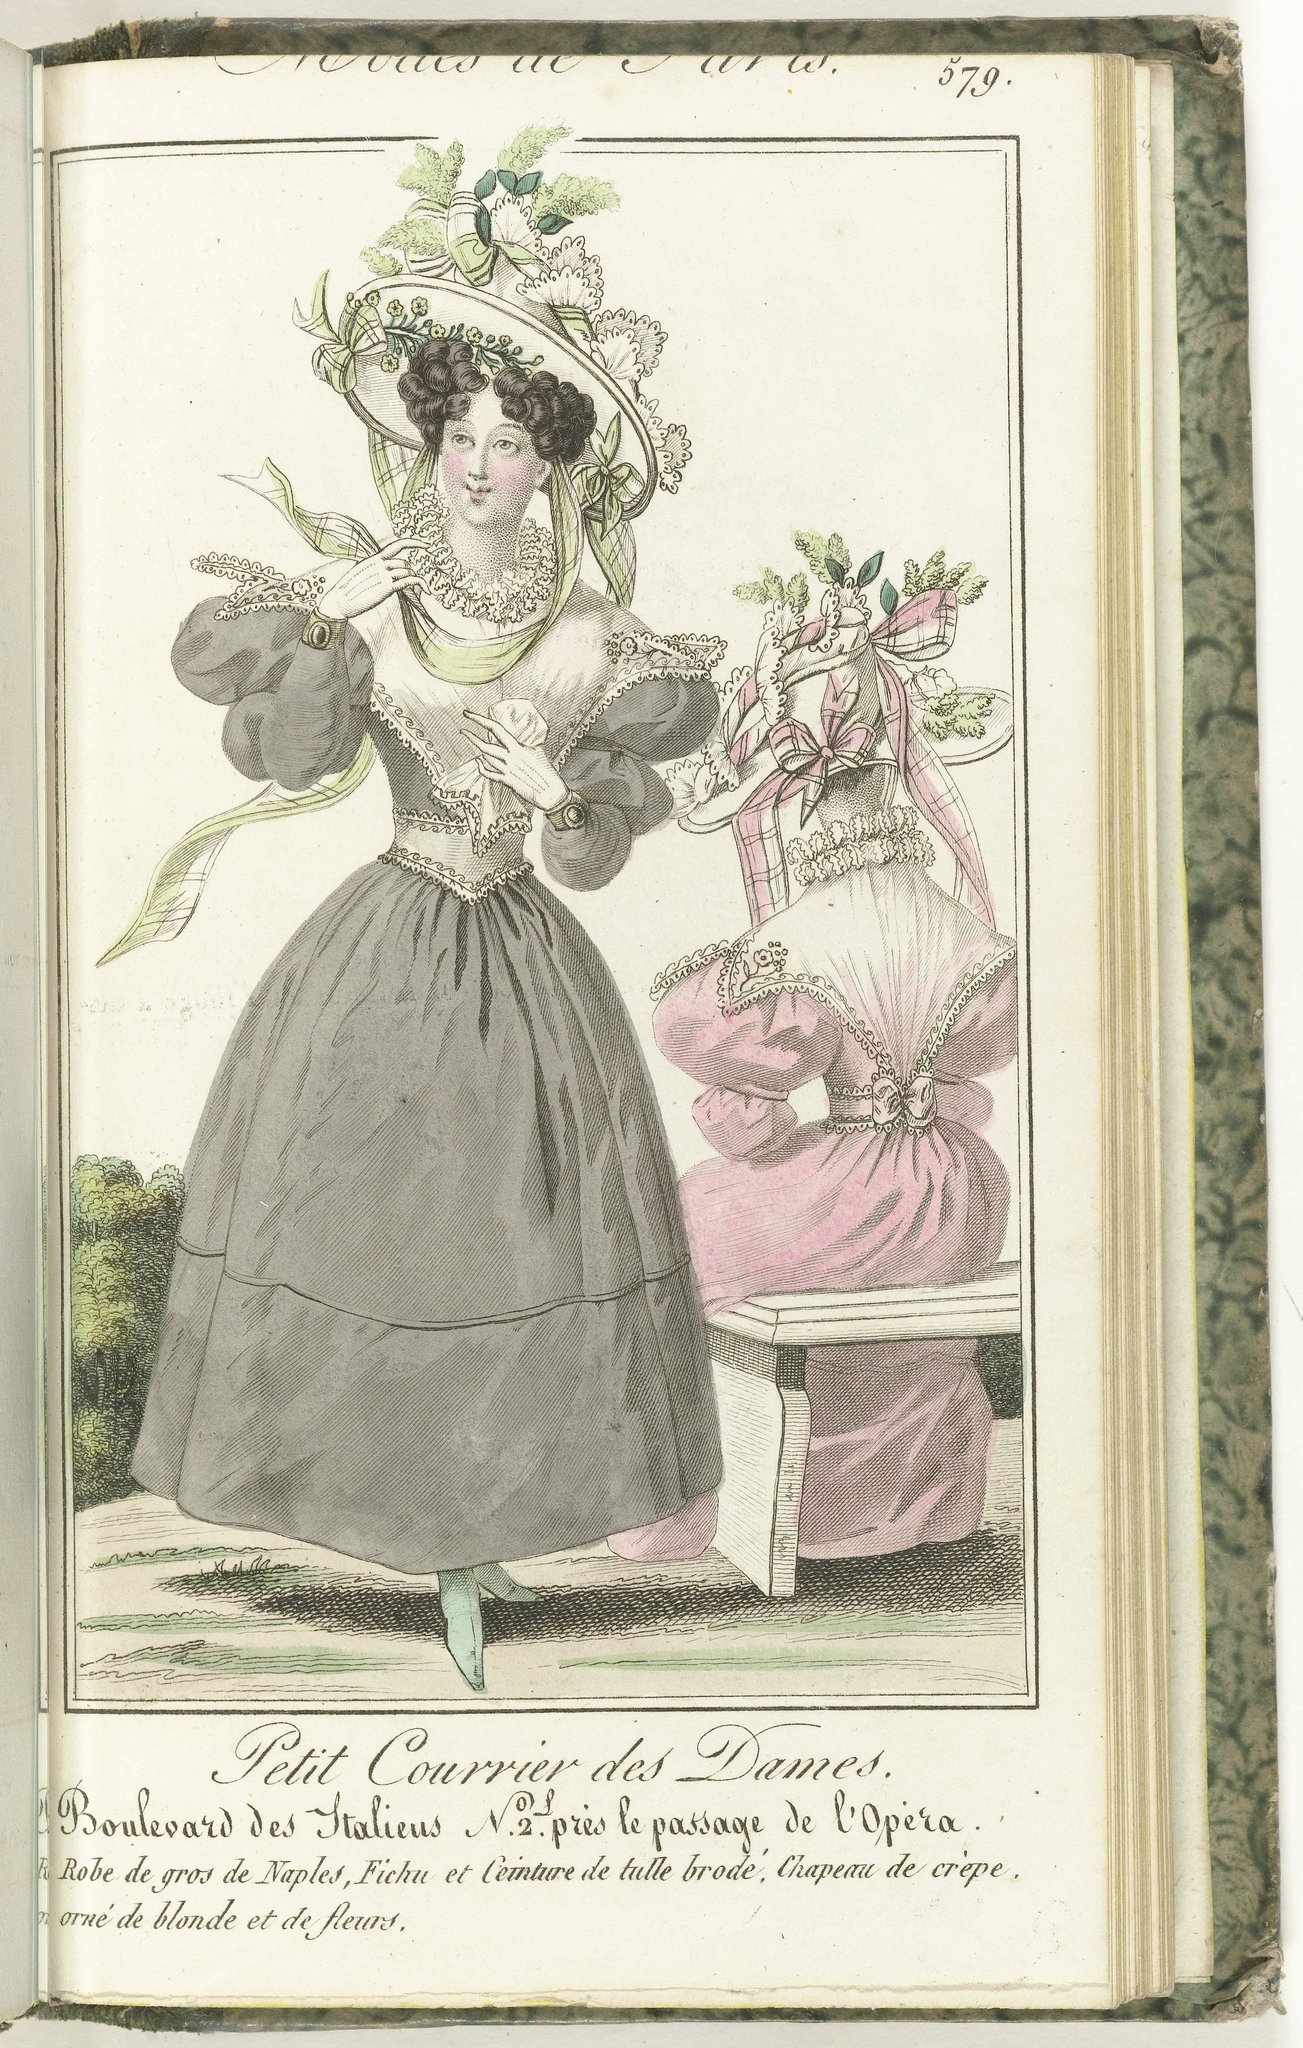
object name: fashion print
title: Petit Courrier des Dames, 31 août 1828, No. 579 : Robe de gros de Naples...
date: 1828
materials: paper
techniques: engraving, hand coloring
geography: paris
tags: handkerchief (+ women's clothes), embroidery (ornamentation) (+ women's clothes), lace (+ women's clothes), fashion plates, head-gear: hat (+ women's clothes), dress, gown (+ women's clothes), piece of clothing covering the breast or décolleté (fichu) (+ women's clothes), belt, girdle, waistband (+ women's clothes)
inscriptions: title: ‘Modes de Paris.’, address: ‘Boulevard des Italiens No.2 près le passage de l'Opèra.’, caption, title: ‘Petit Courrier des Dames.’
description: Staande vrouw gekleed in een japon van 'gros de Naples'. fichu en Ceintuur van geborduurde tule. Op het hoofd een hoed van crêpe versierd met Blonde (kloskant) en bloemen. Zittende figuur in eenzelfde japon, op de rug gezien. Prent uit het modetijdschrift Petit Courrier des Dames (1821-1868). Ingebonden (met enkele pp. Le Journal des Dames et des Modes). 15 Januari 1827 t/m 20 maart 1830. Incompleet.